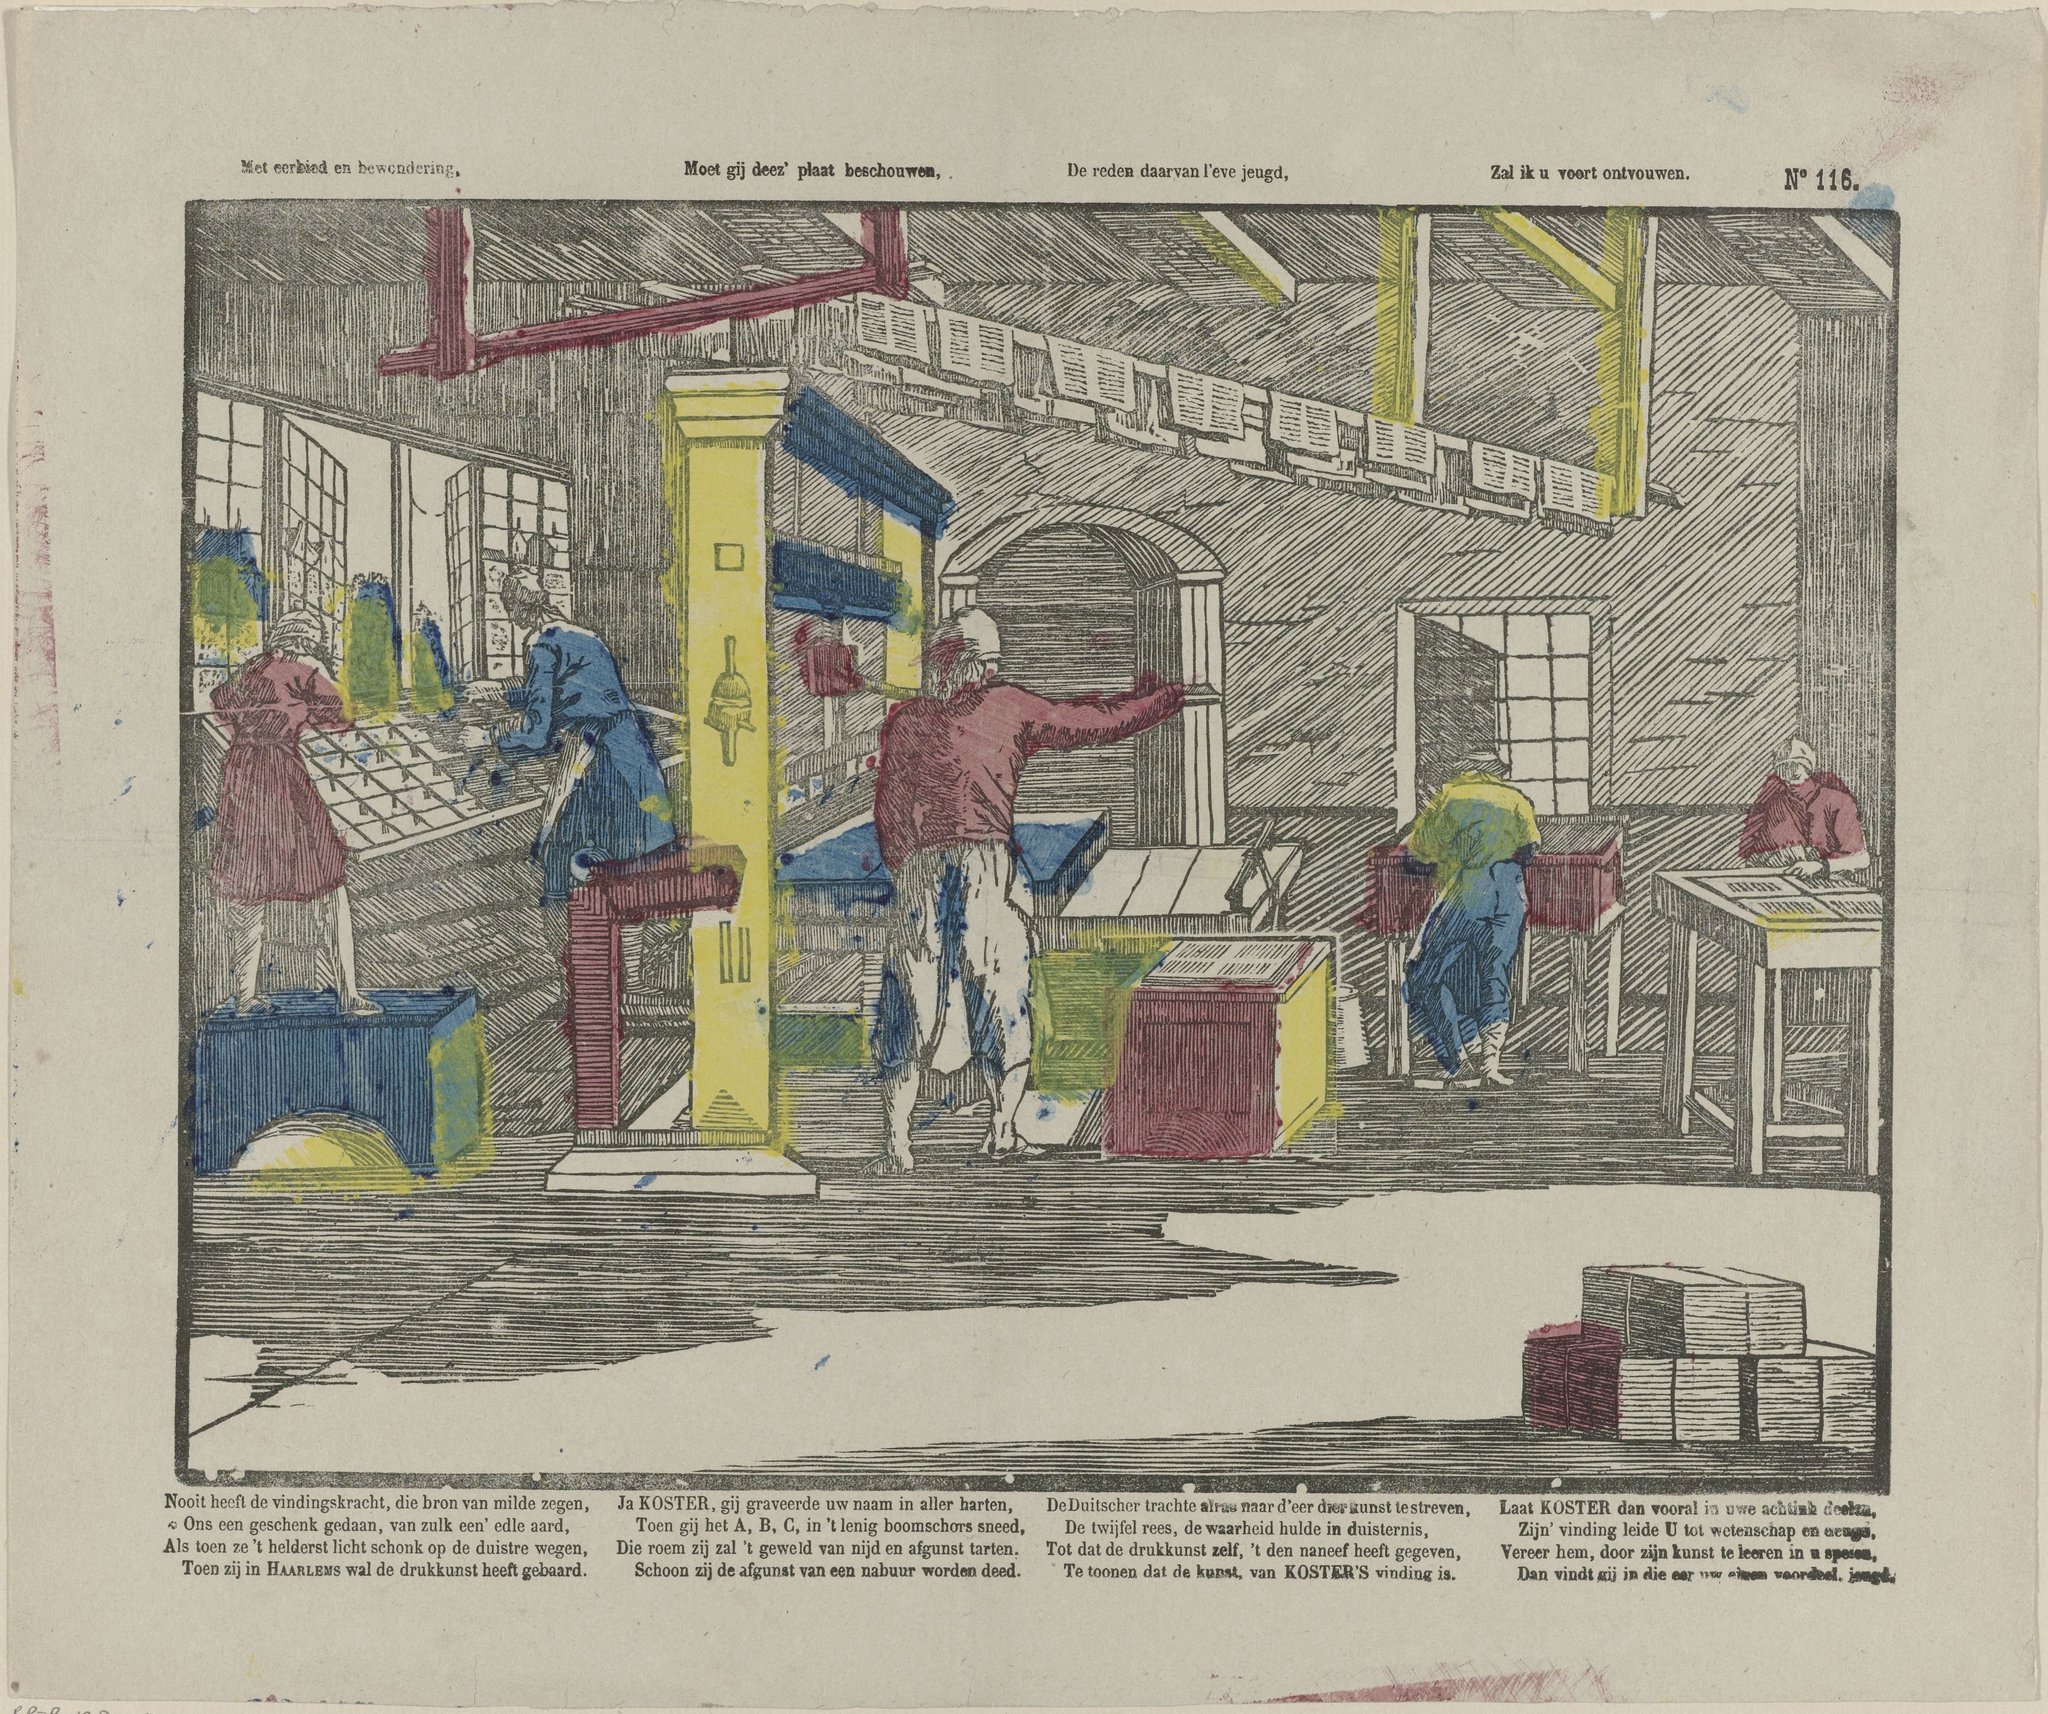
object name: print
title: Met eerbied en bewondering, / Moet gij deez' plaat beschouwen, / De reden daarvan l'eve jeugd, / Zal ik u voort ontvouwen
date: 1827-1894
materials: paper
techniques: colour, letterpress printing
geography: schaarbeek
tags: tools, aids, implements ~ crafts and industries: press, printing press, printer, tools, implements of printer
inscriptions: collector's mark: Lugt 2228, collector's mark: Lugt 2760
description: Blad met een grote voorstellingen van een drukkerij (mogelijk die van Laurens Jansz. Coster). Links twee mannen bij letterbakken, centraal een man die de drukpers bedient en rechts twee mannen die gedrukte vellen staan te redigeren. Boven hangen pas gedrukte bladen over balken te drogen. In de ondermarge een onderschrift in vier kolommen. Genummerd rechtsboven: No. 116.